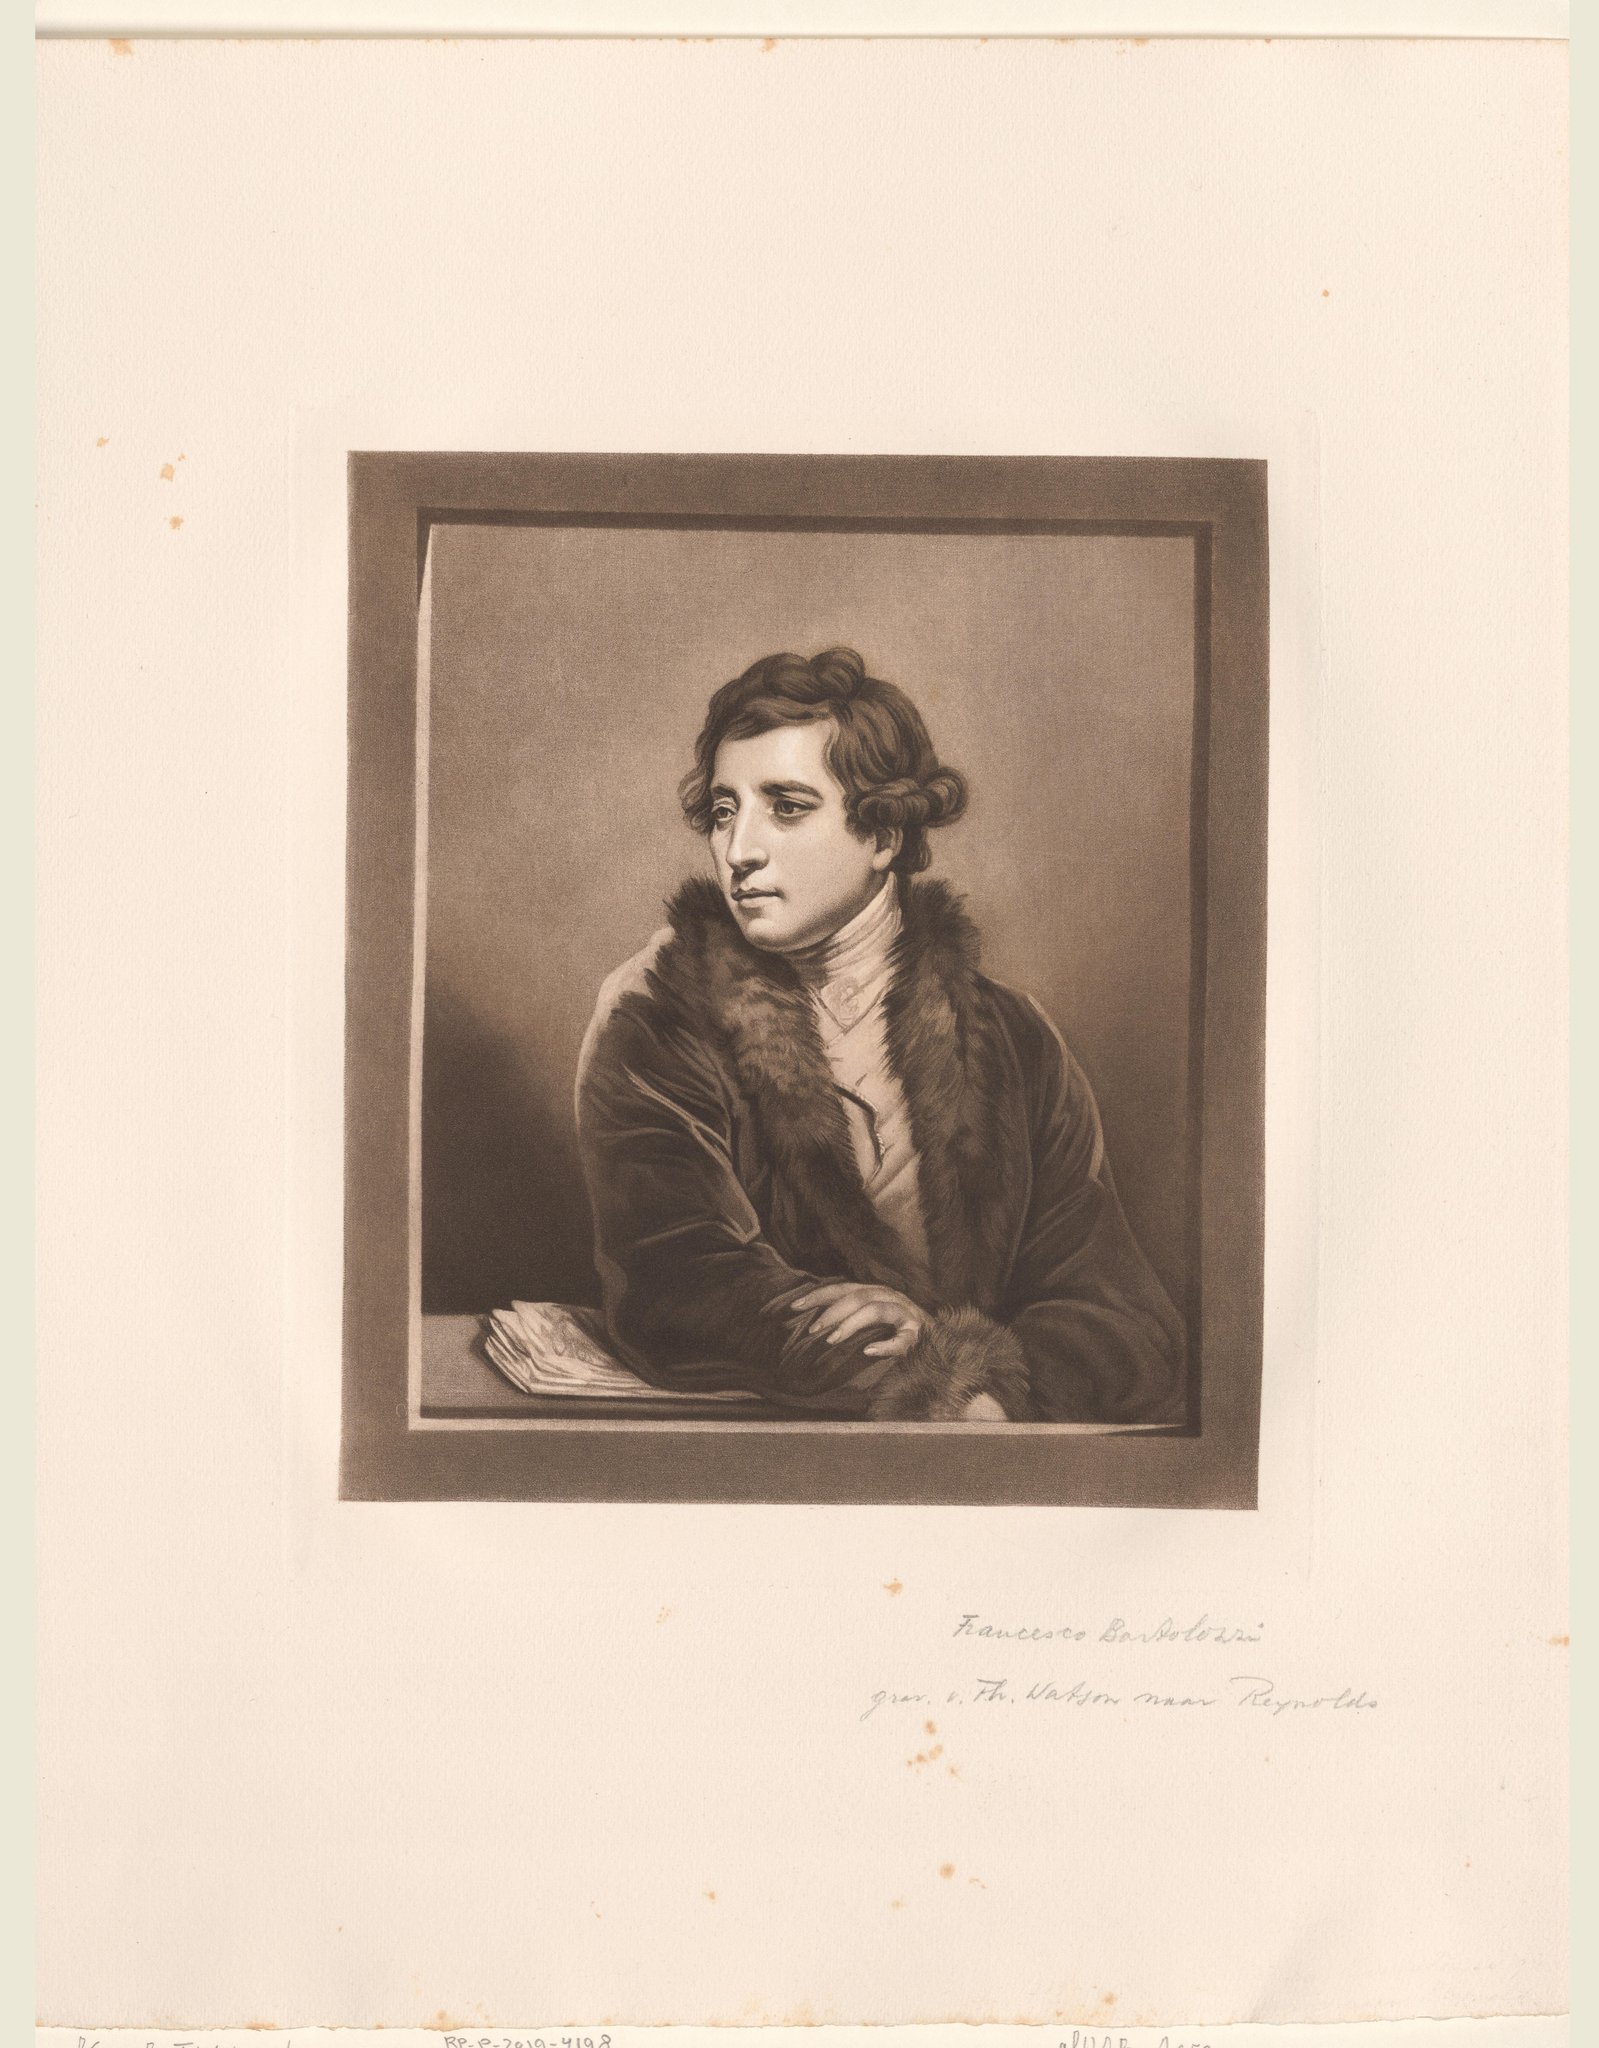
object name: photomechanical print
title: Portret van Francesco Bartolozzi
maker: Anonymous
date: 1850-1899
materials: paper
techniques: photoaquatint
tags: print maker, draughtsman, francesco bartolozzi, historical persons, portrait, self-portrait of artist